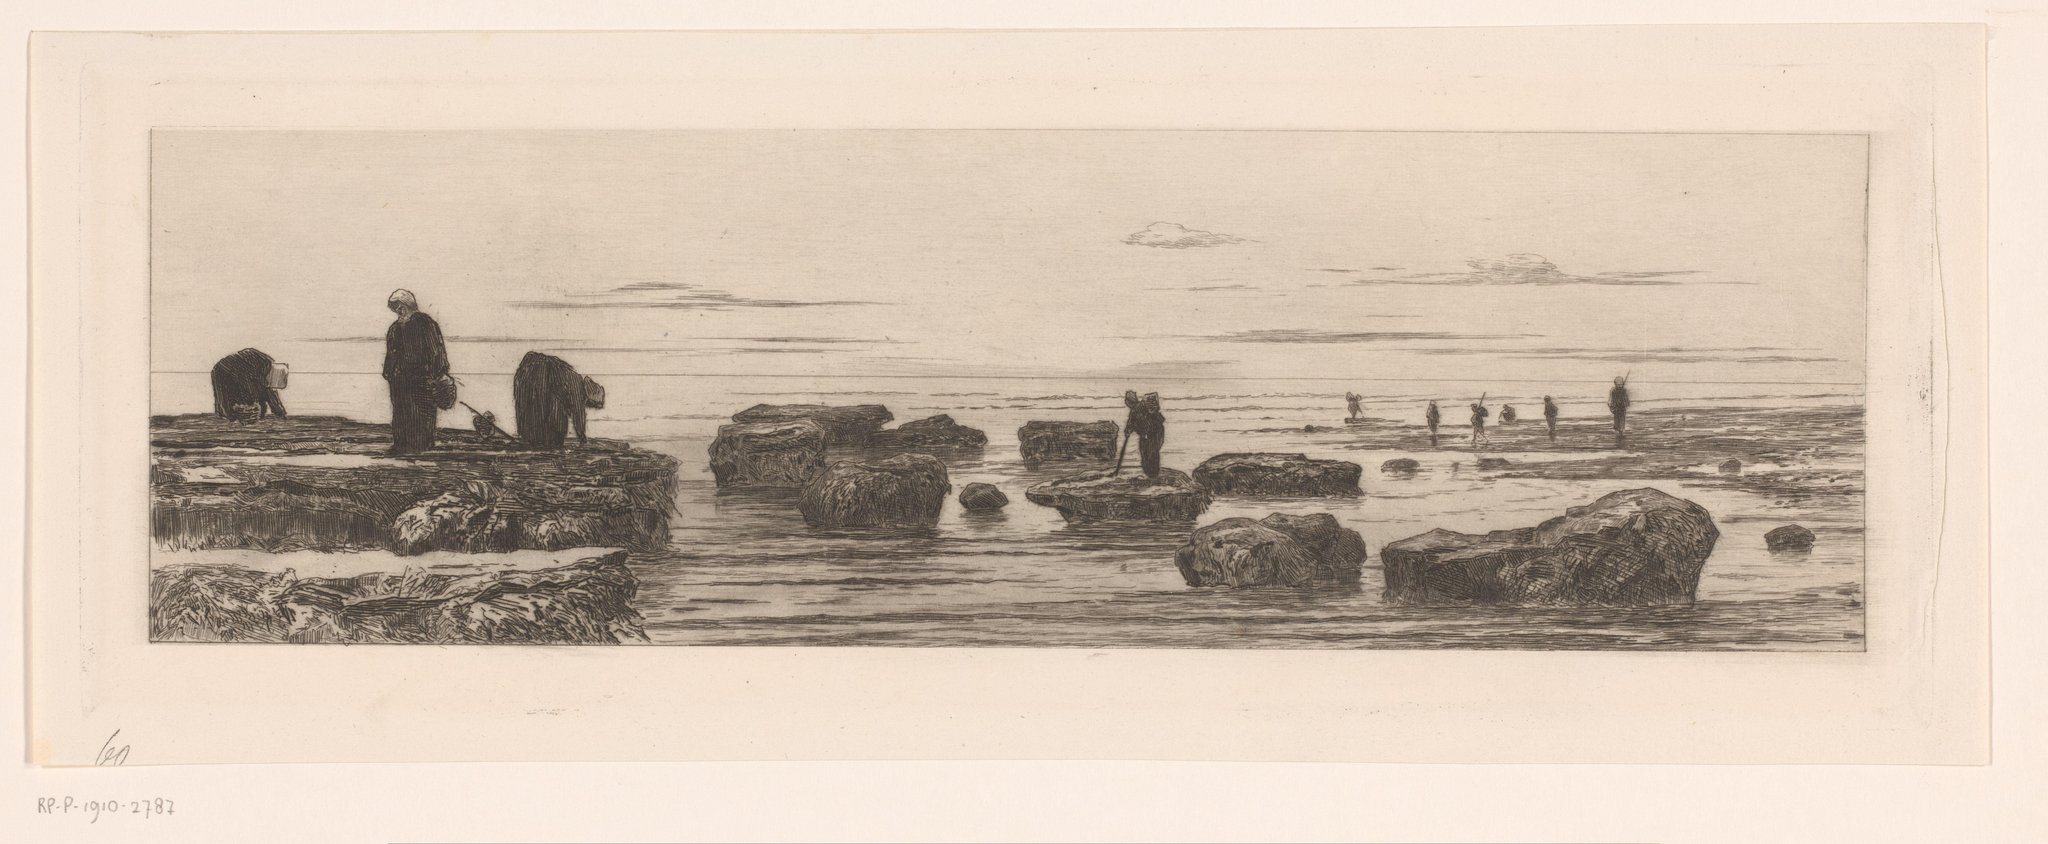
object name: print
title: Souvenir du Hâvre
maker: carel nicolaas storm van s-gravesande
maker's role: draughtsman, print maker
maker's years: 1841-1924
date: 1873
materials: paper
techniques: etching, intaglio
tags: gathering herbs, beach (+ landscape with figures, staffage)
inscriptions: collector's mark: Lugt 2228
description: Gezicht op een strand met rotsblokken waar mensen zeewier aan het plukken zijn in de branding.